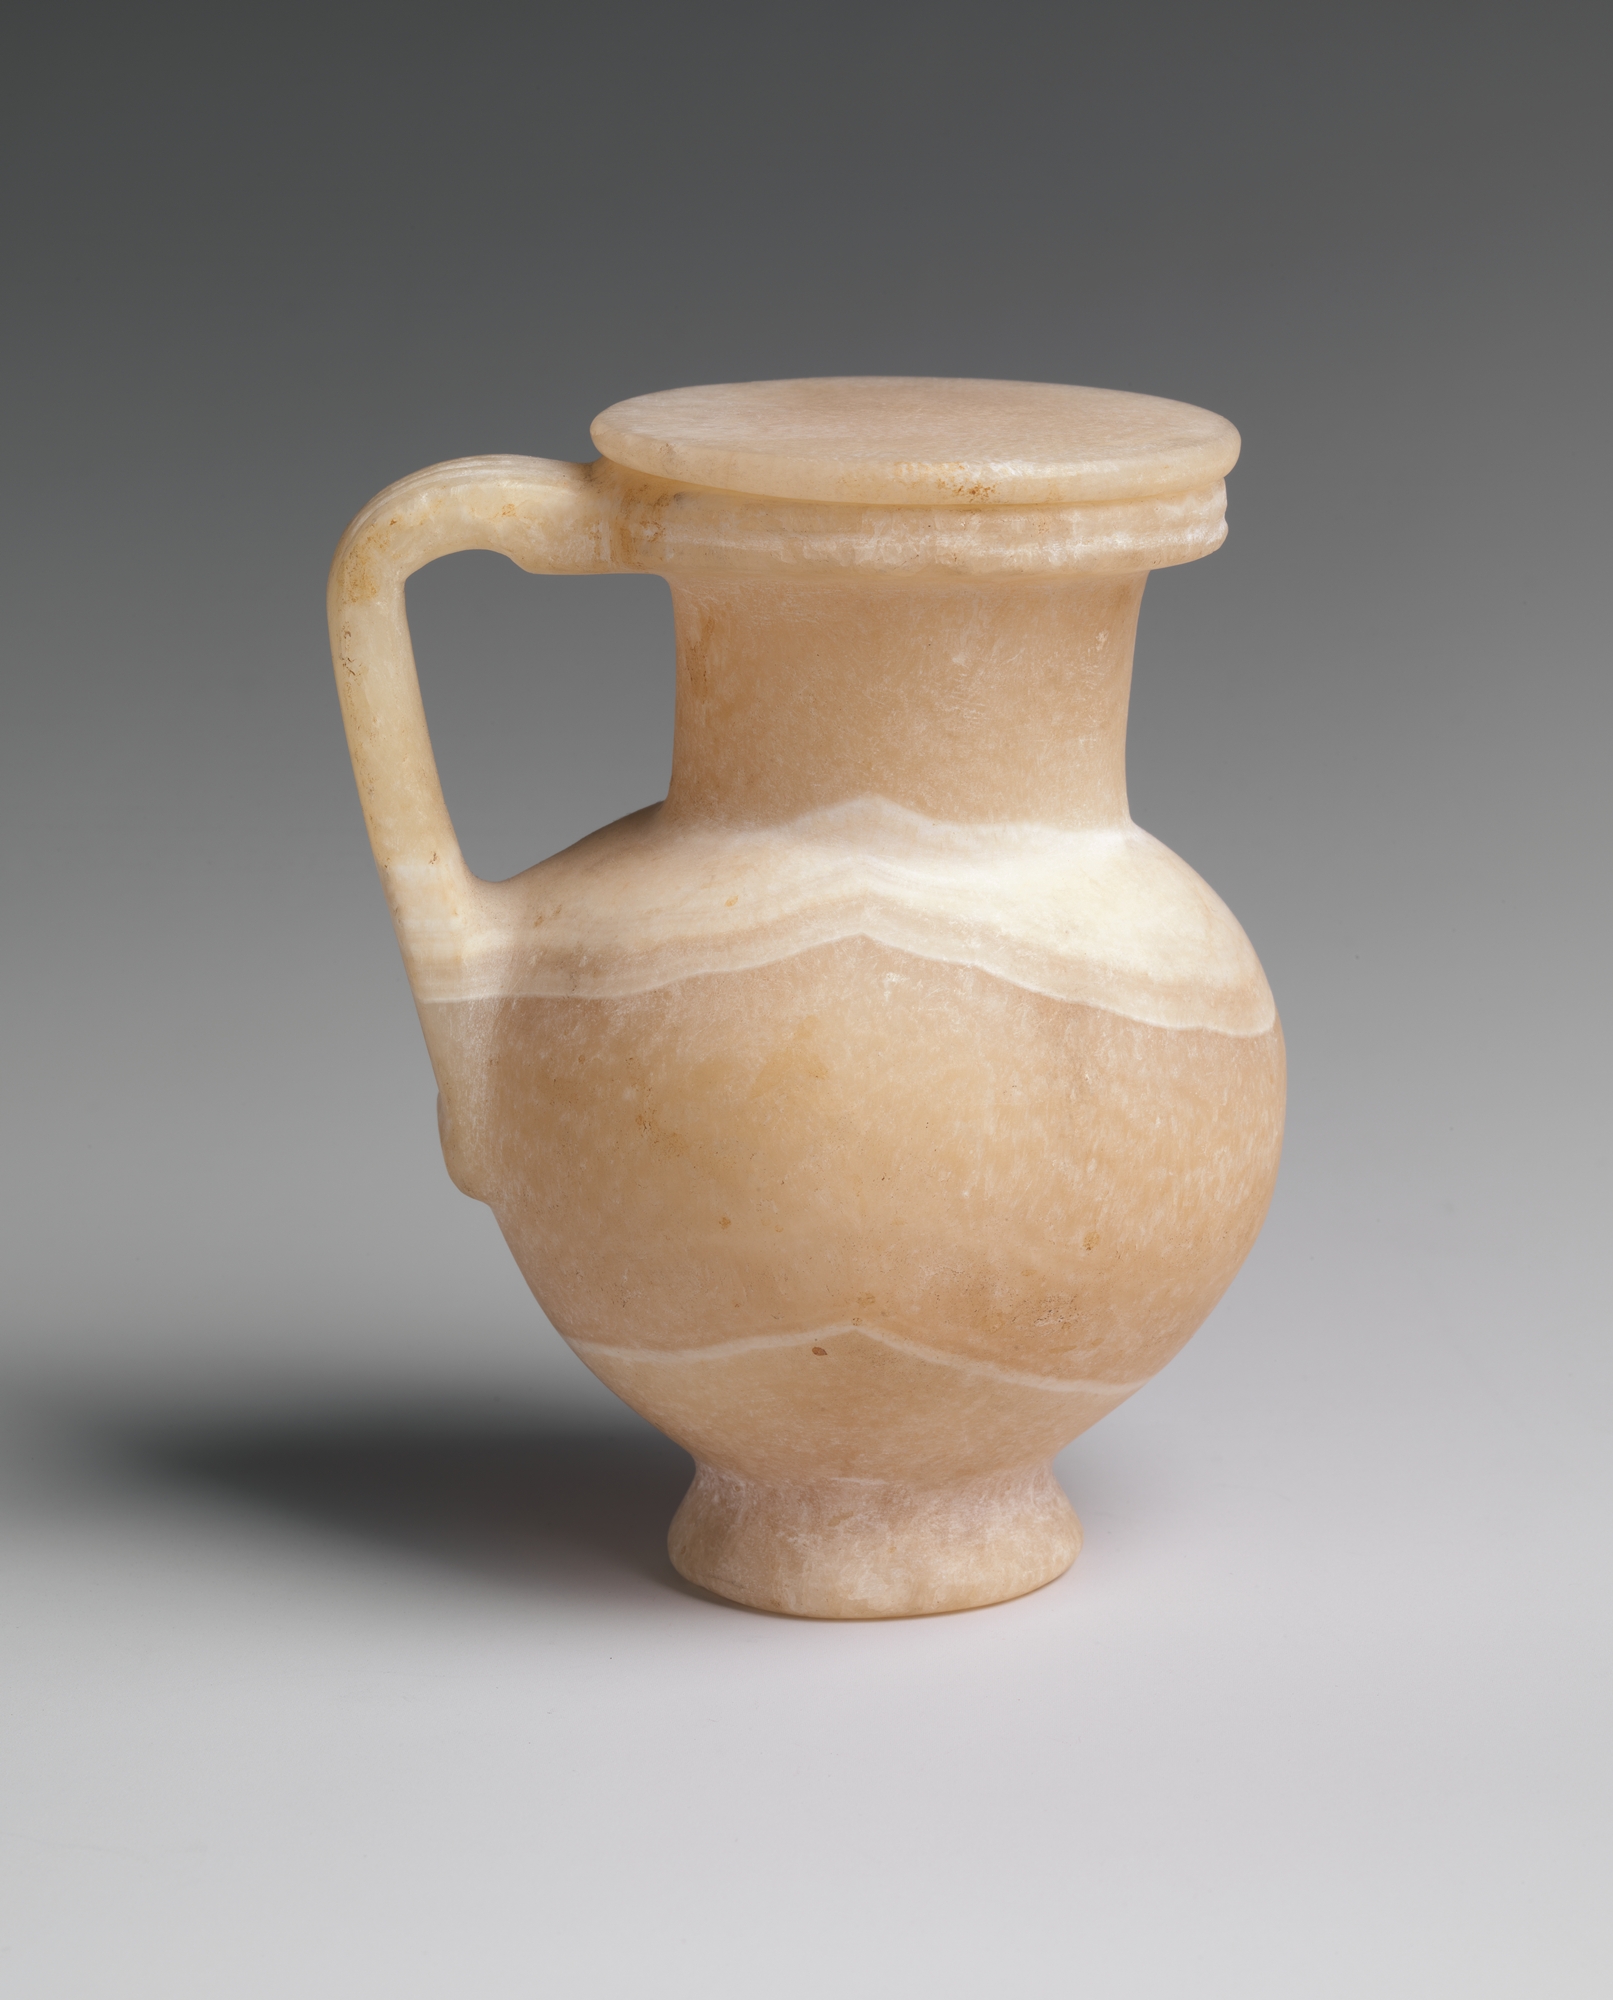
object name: jug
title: Stone Jug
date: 1550-1458 BCE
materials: stone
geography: egypt